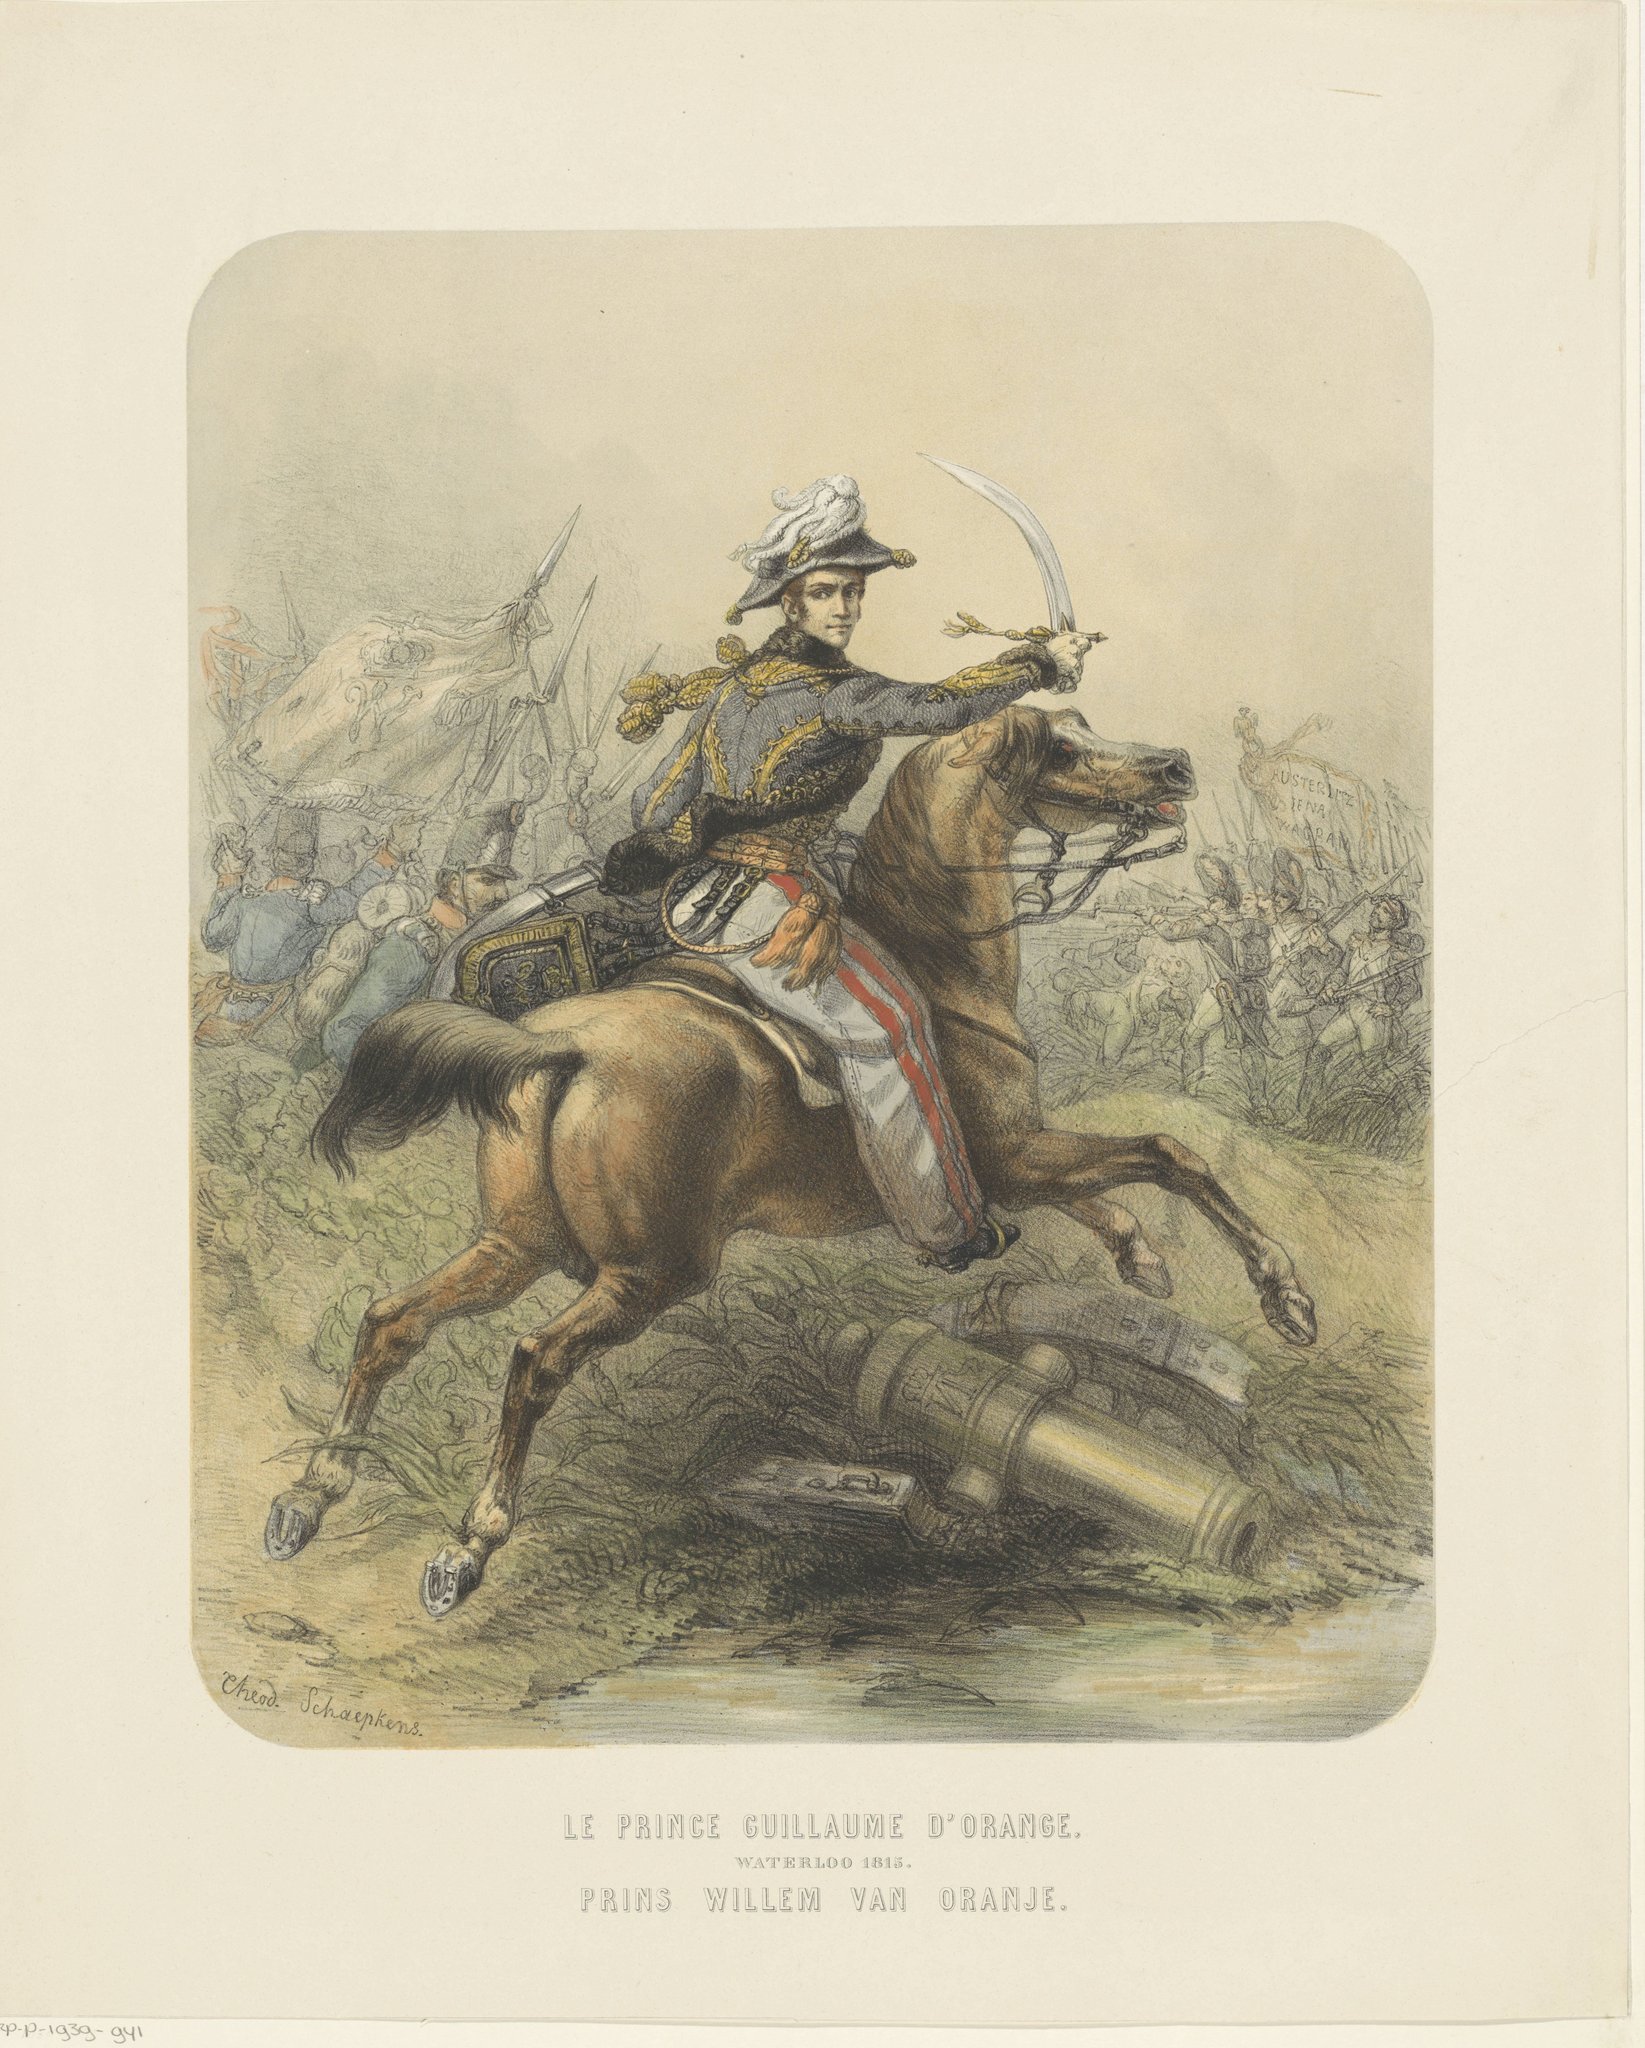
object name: print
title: Ruiterportret van Willem II, koning der Nederlanden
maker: theodoor schaepkens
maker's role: draughtsman, print maker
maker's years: 1810-1883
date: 1815-1883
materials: paper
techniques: hand coloring, lithograph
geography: antwerp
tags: the hague, william ii of the netherlands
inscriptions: collector's mark: Lugt 2760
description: De hier vermelde titel verwijst naar de hoogst verkregen titel van de geportretteerde, niet per se naar de titel die de geportretteerde op deze voorstelling draagt.